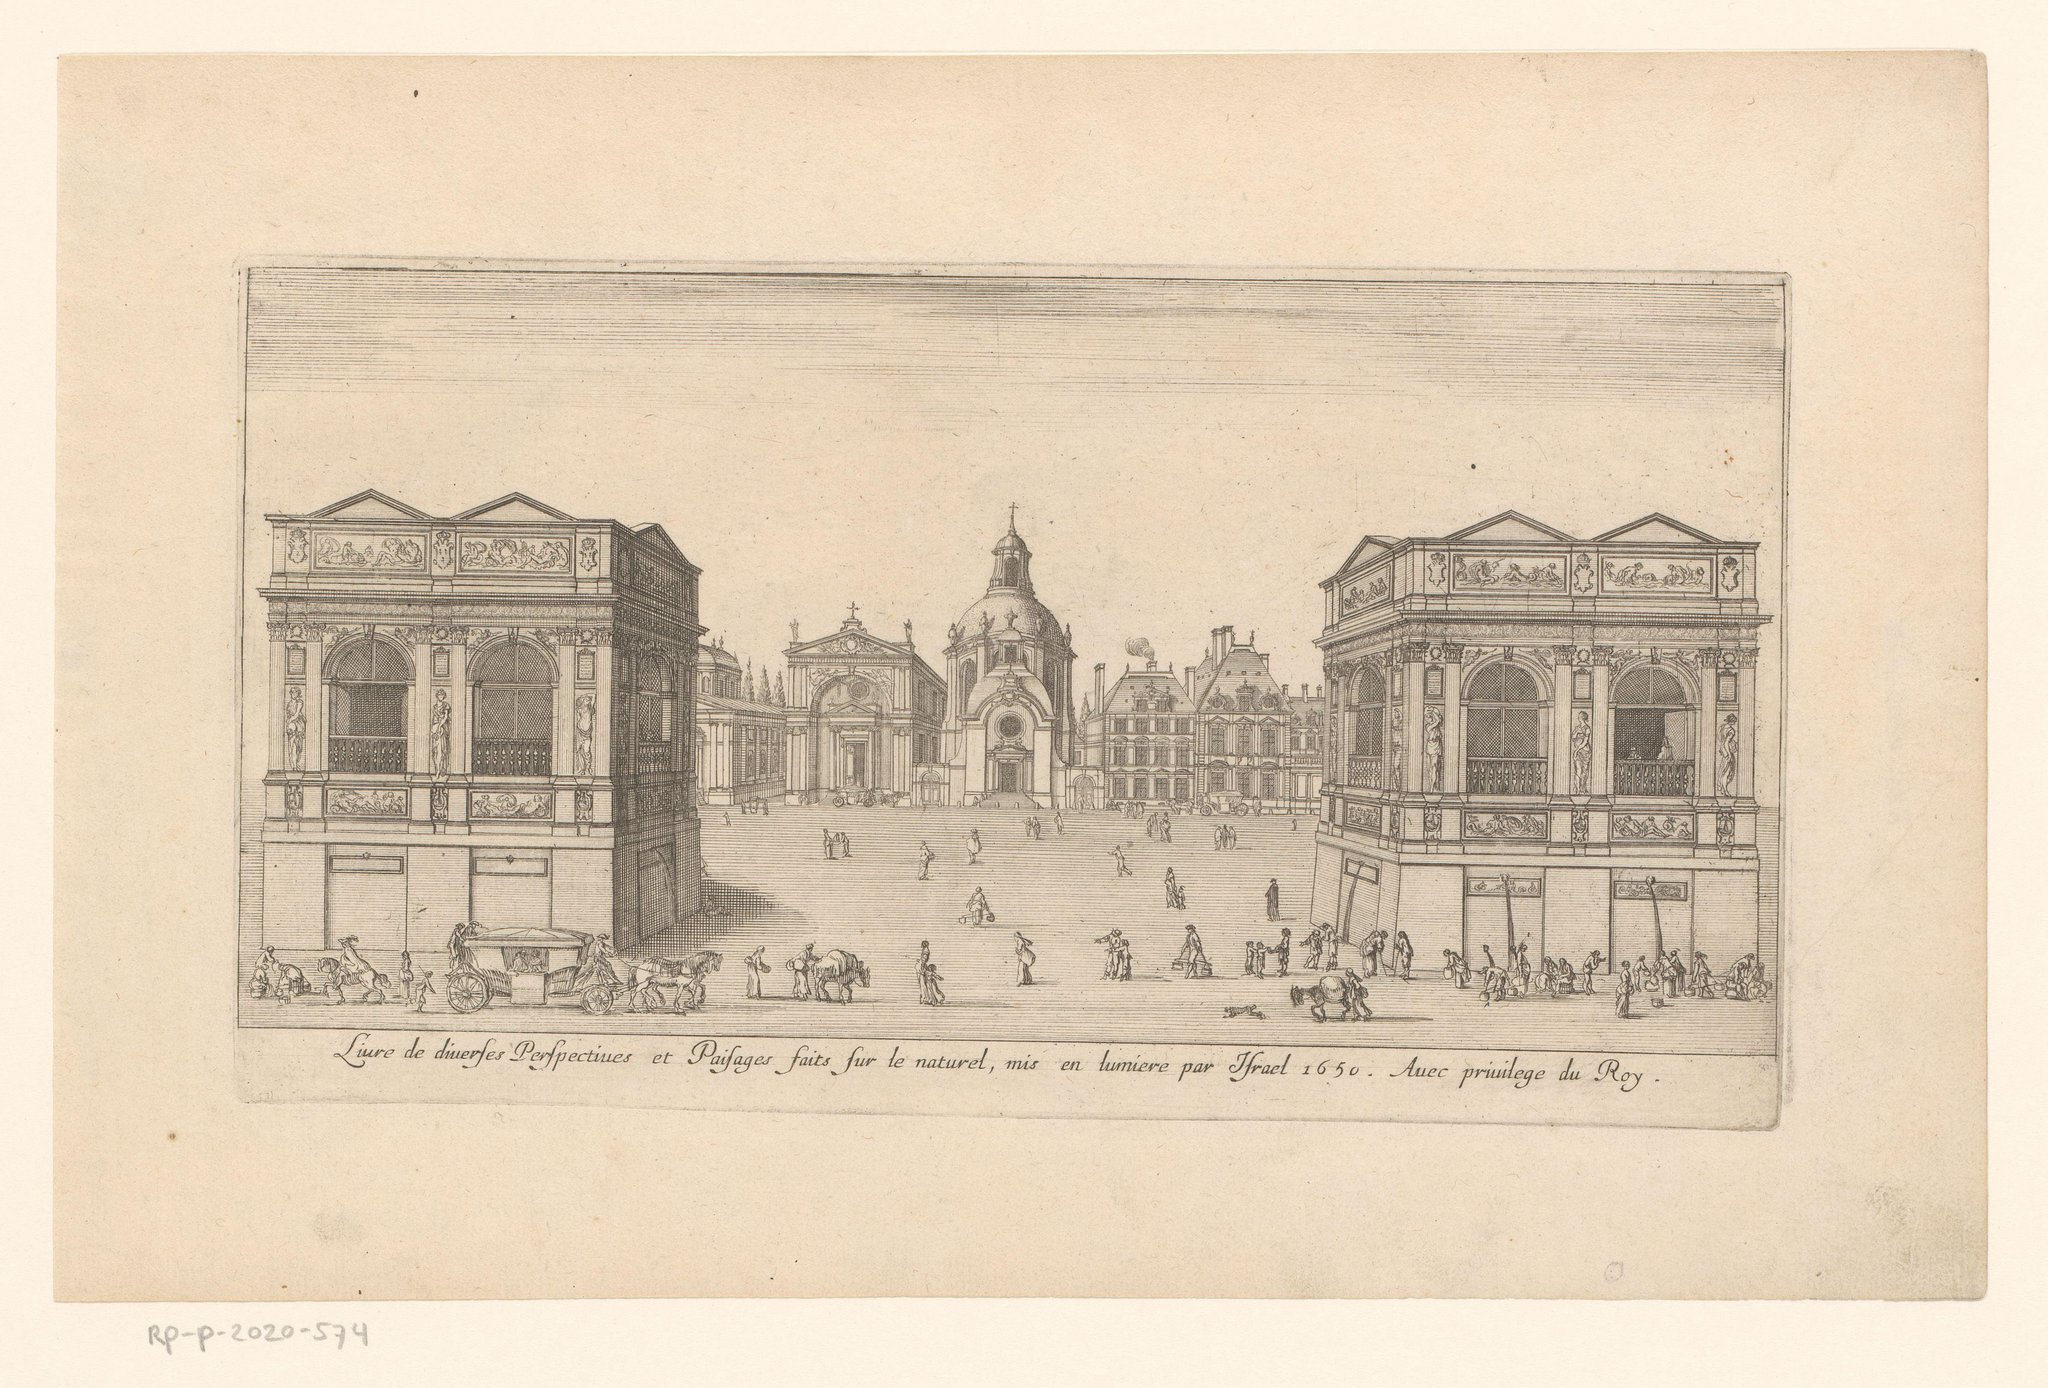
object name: titelprent, frontispice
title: Diverse kastelen, tuinen en stadsgezichten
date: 1650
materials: paper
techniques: etching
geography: paris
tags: church (exterior), street (+ city(-scape) with figures, staffage)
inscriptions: collector's mark: Lugt 2228